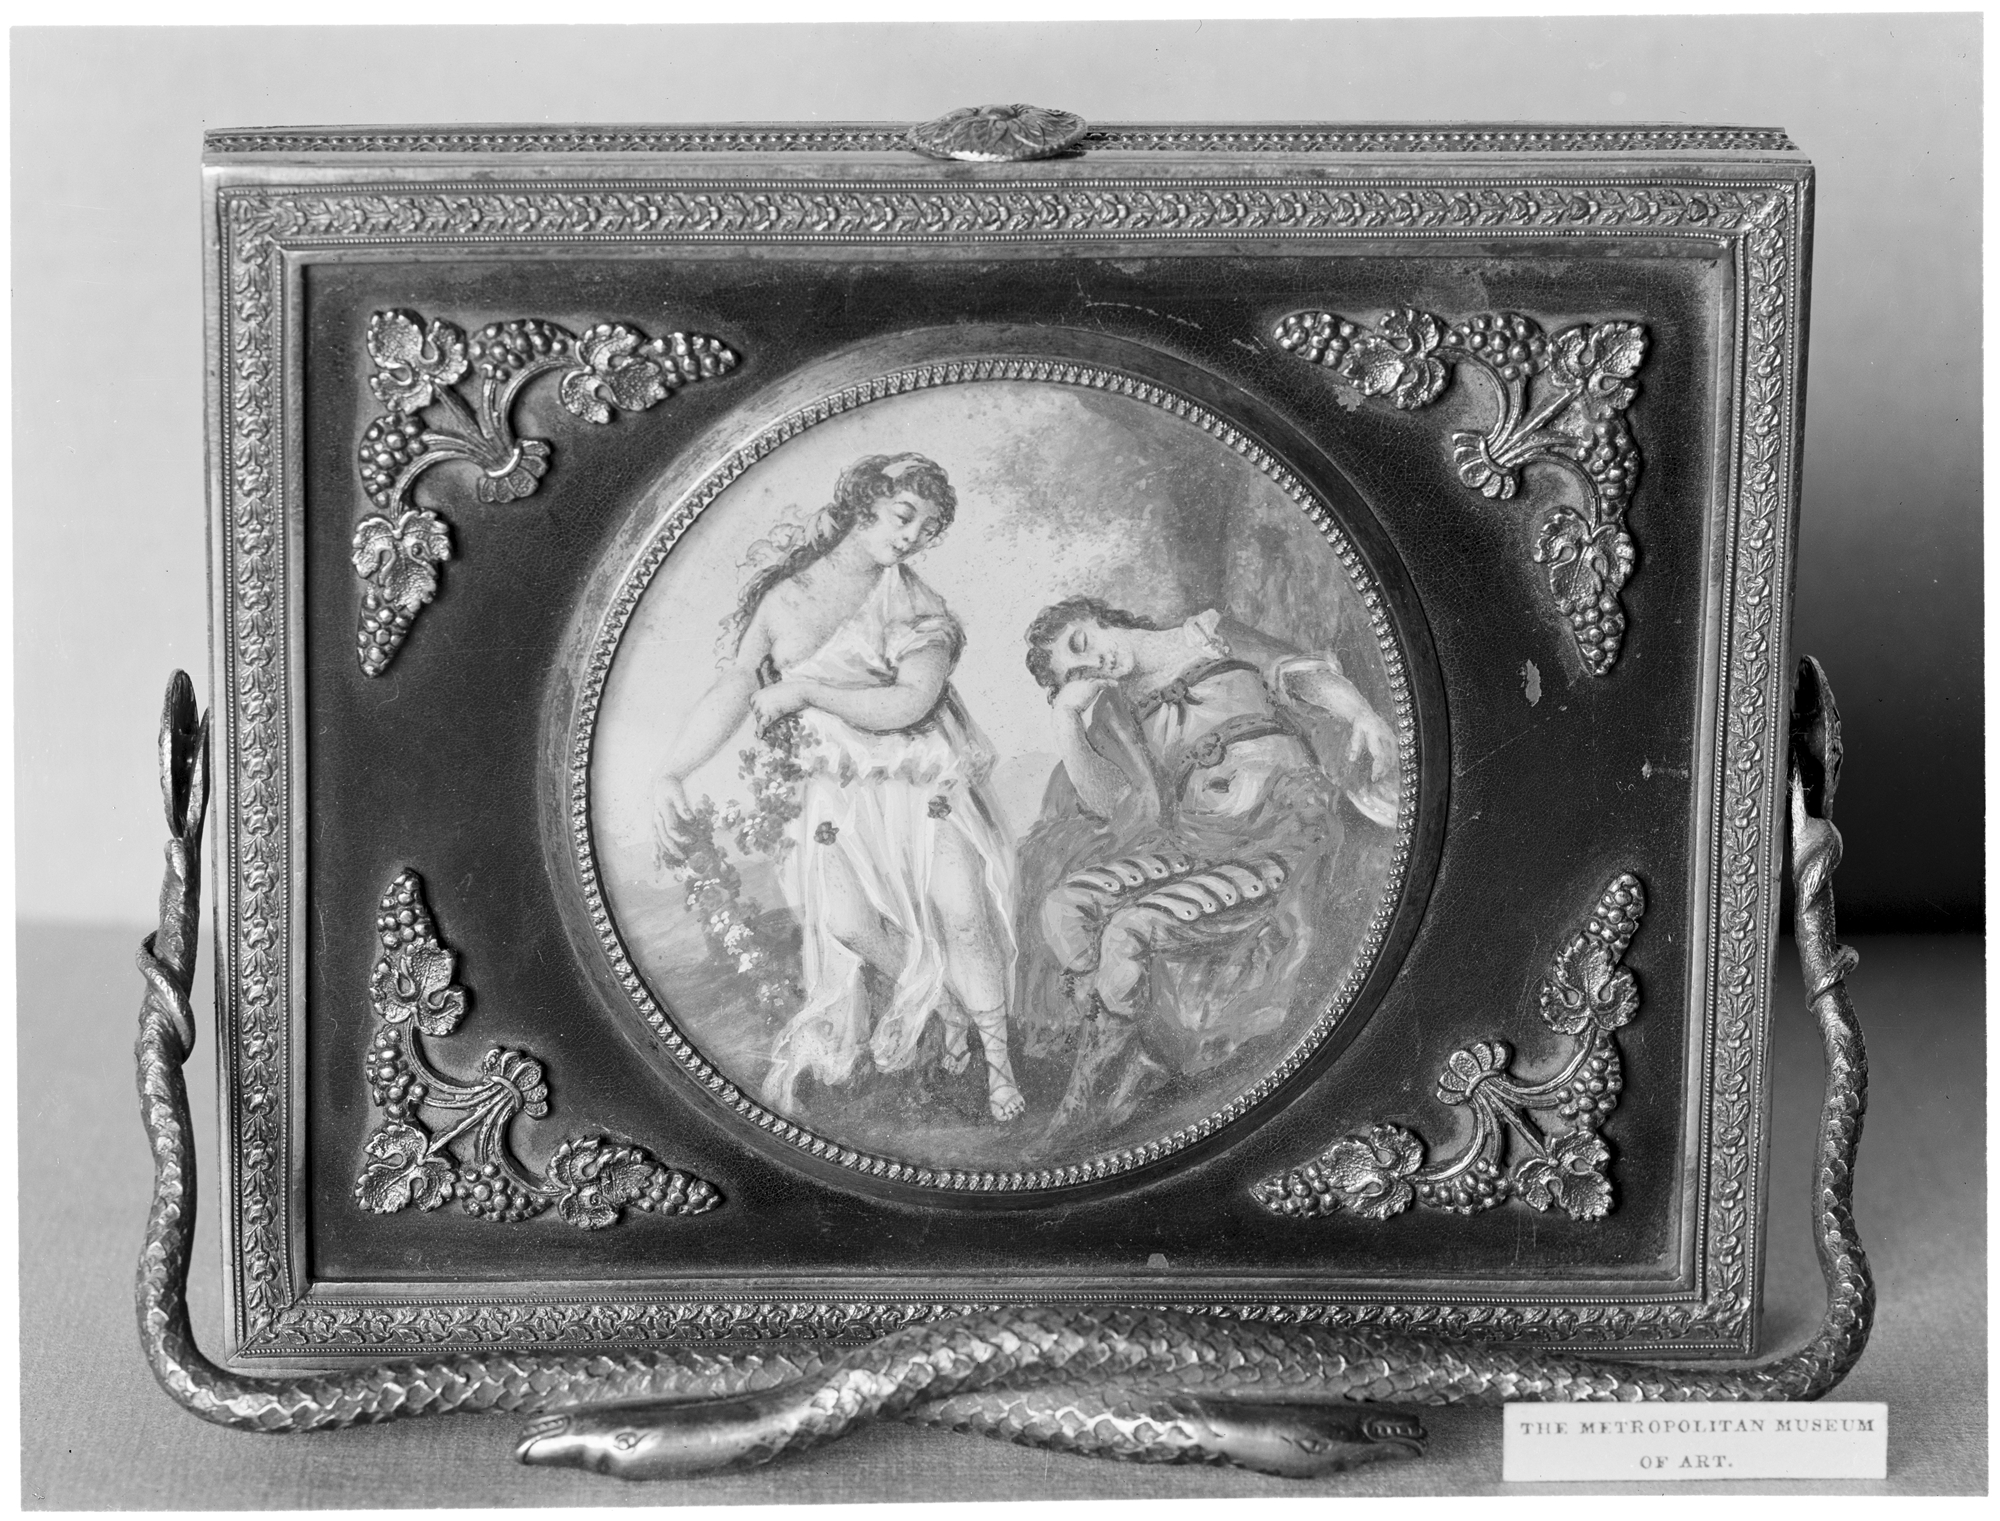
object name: paperweight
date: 1830-1840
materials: gilt bronze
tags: men,women